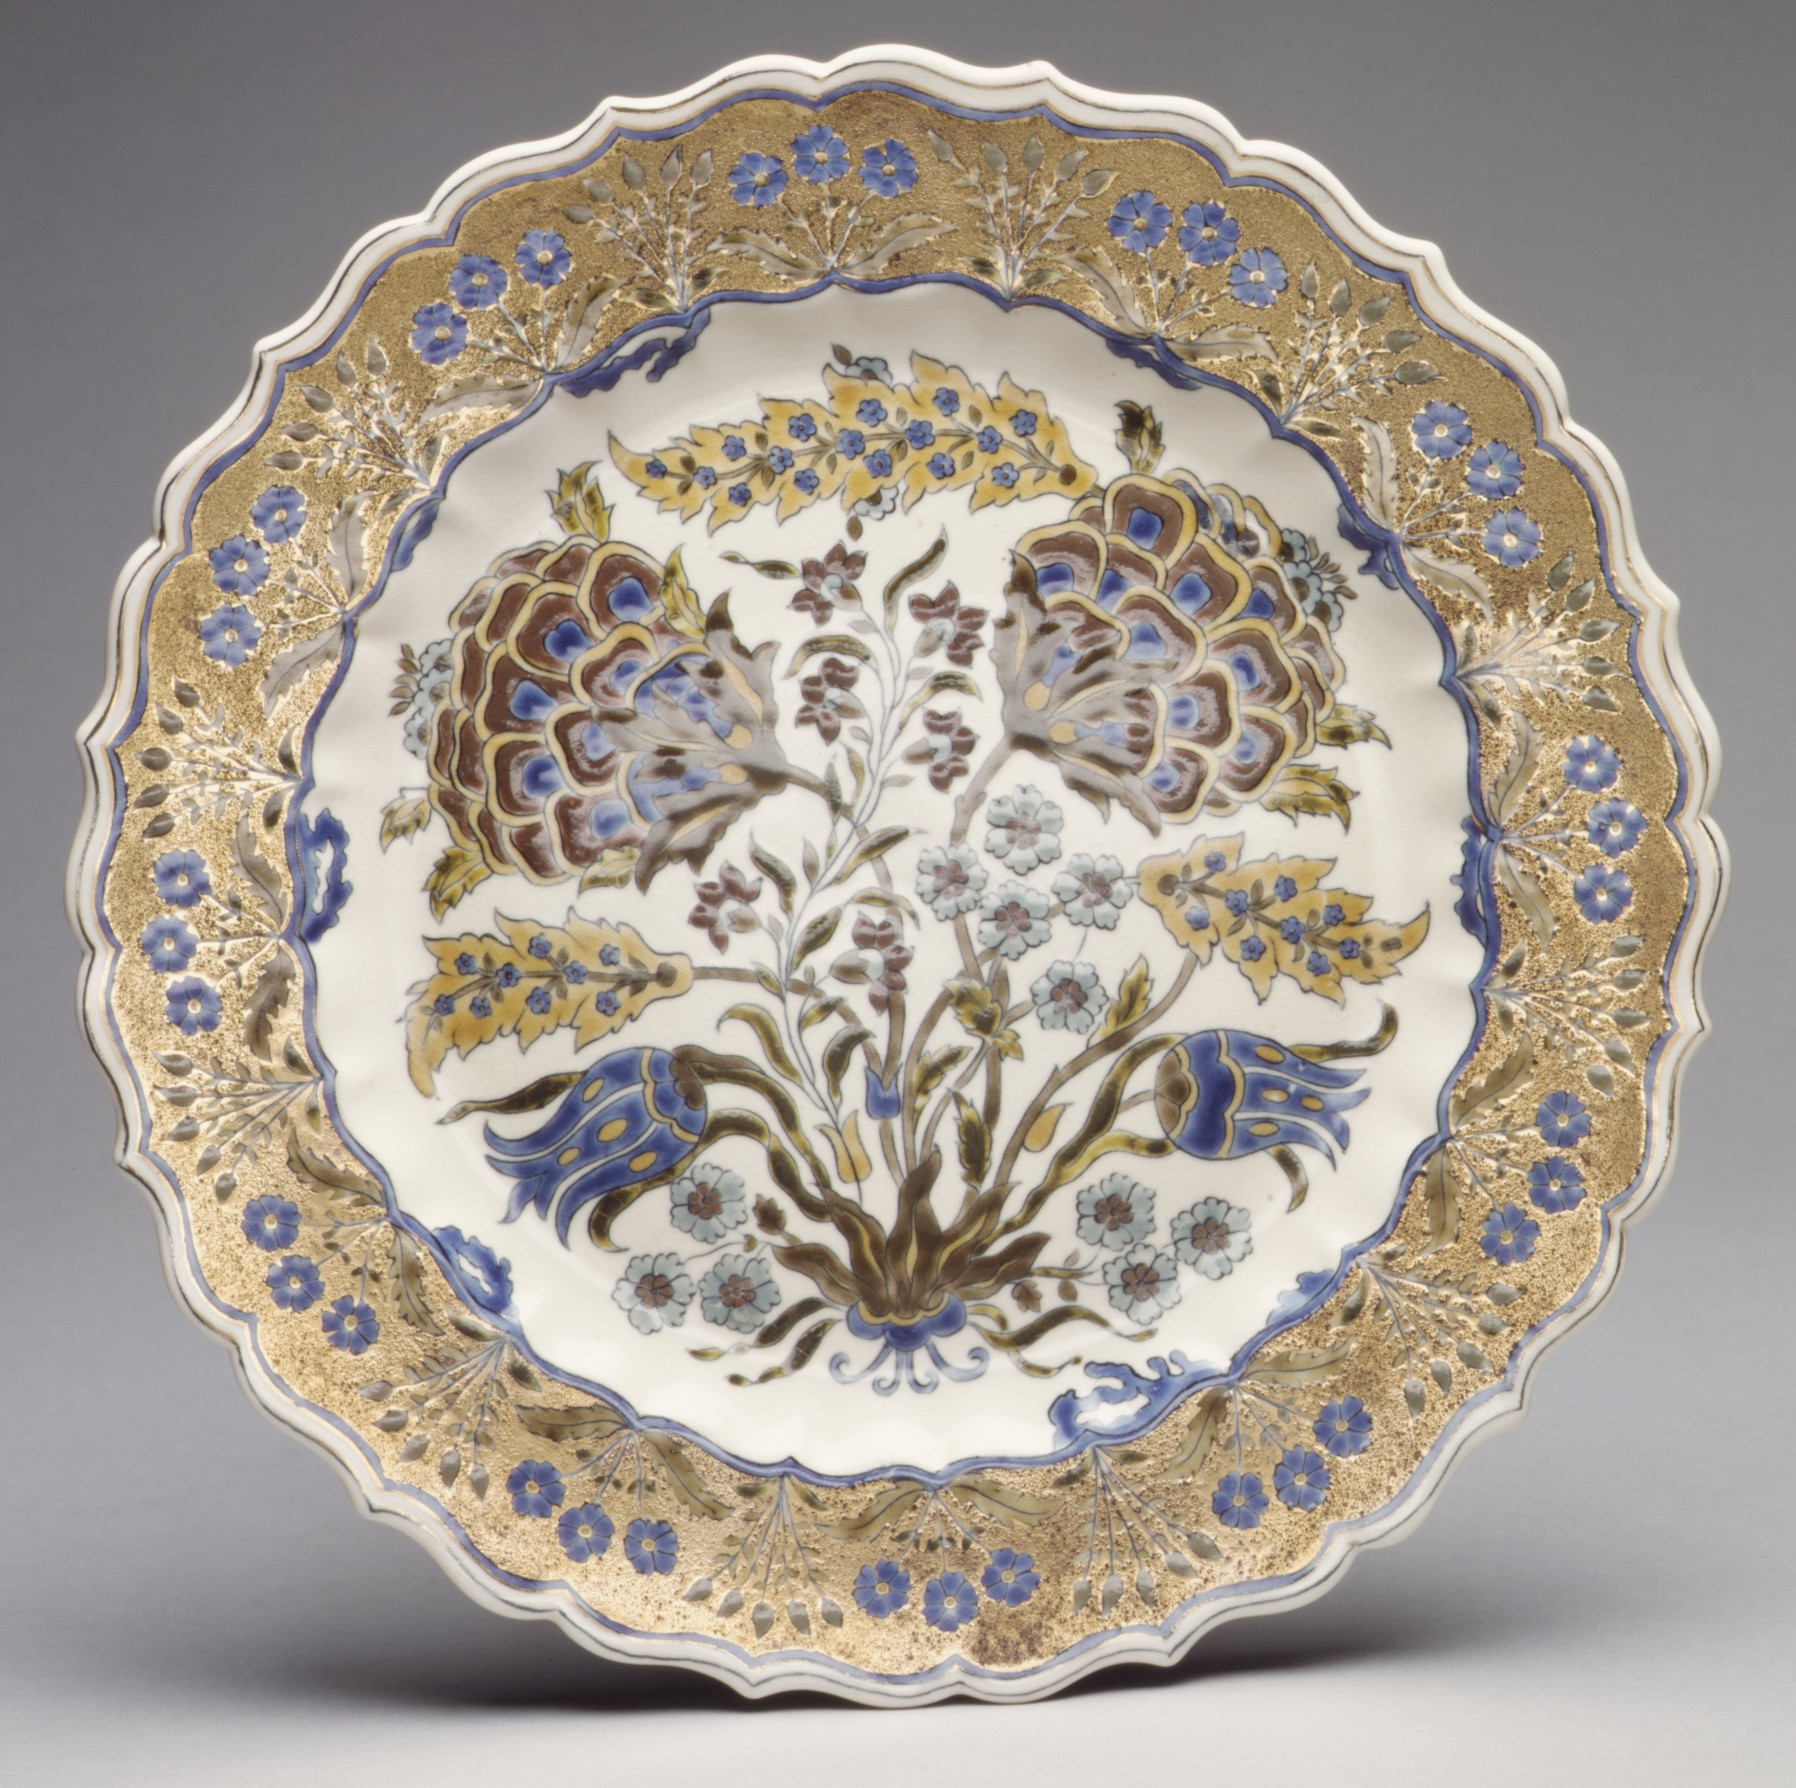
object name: plate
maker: zsolnay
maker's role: factory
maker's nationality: hungarian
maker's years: 1853-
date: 1880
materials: earthenware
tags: flowers